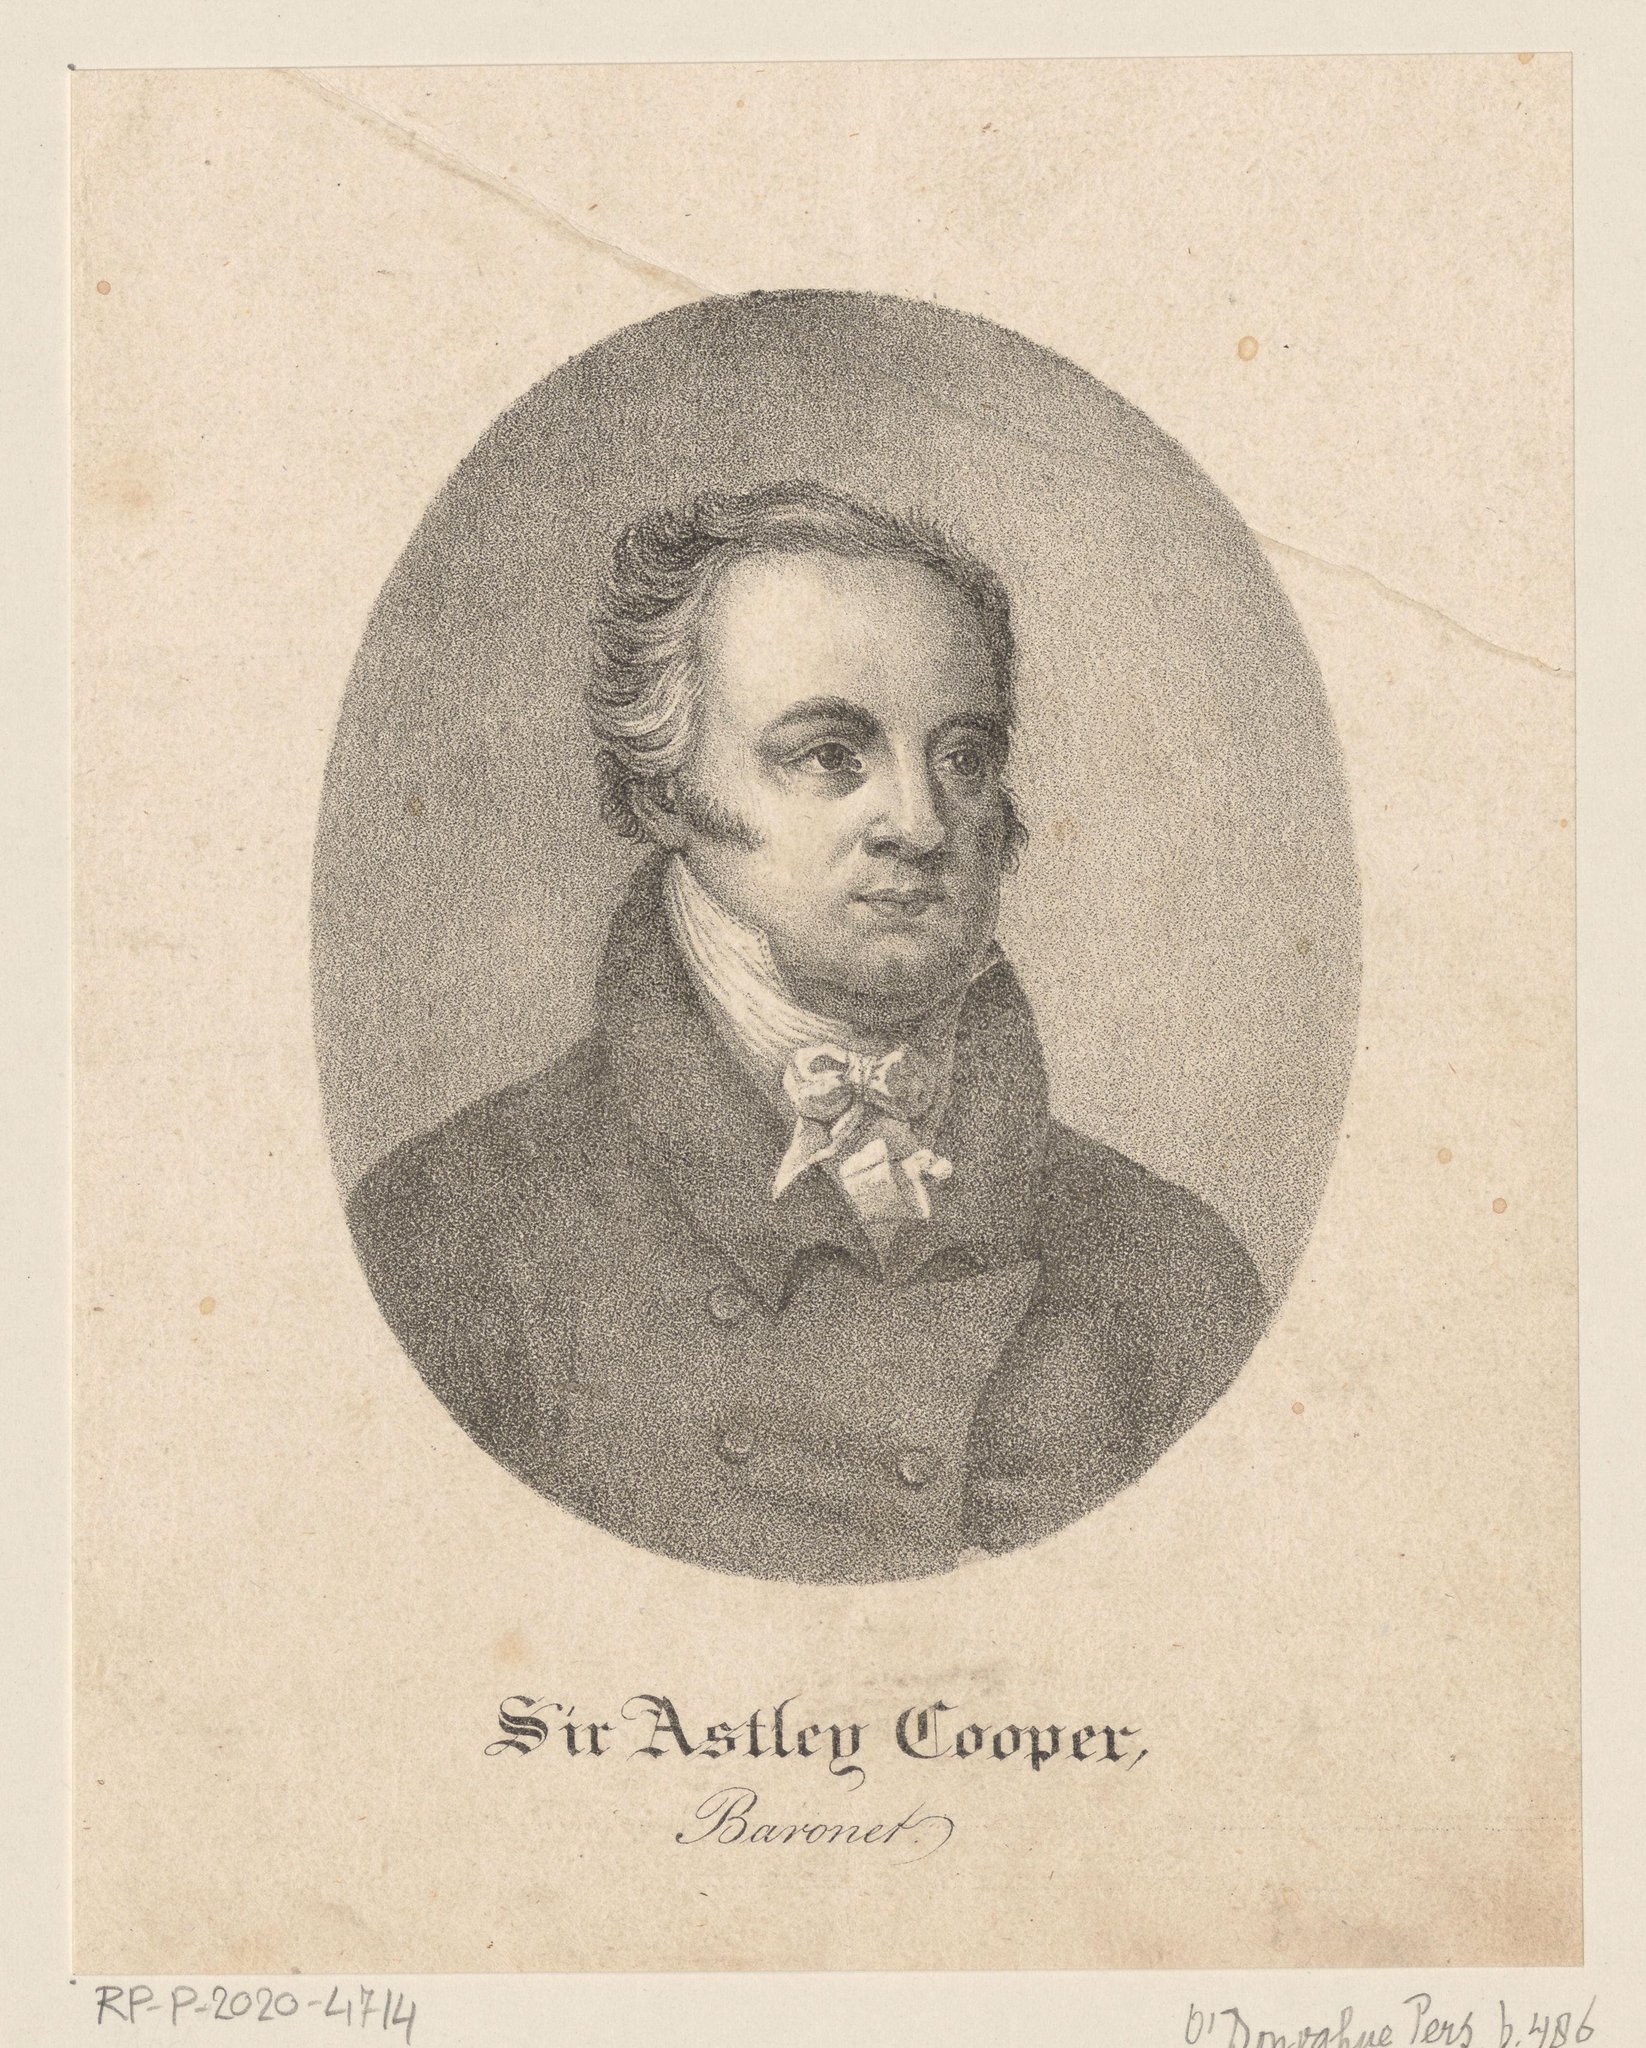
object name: print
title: Portret van Sir Astley Paston Cooper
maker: Anonymous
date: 1677-1749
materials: paper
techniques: lithograph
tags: historical persons